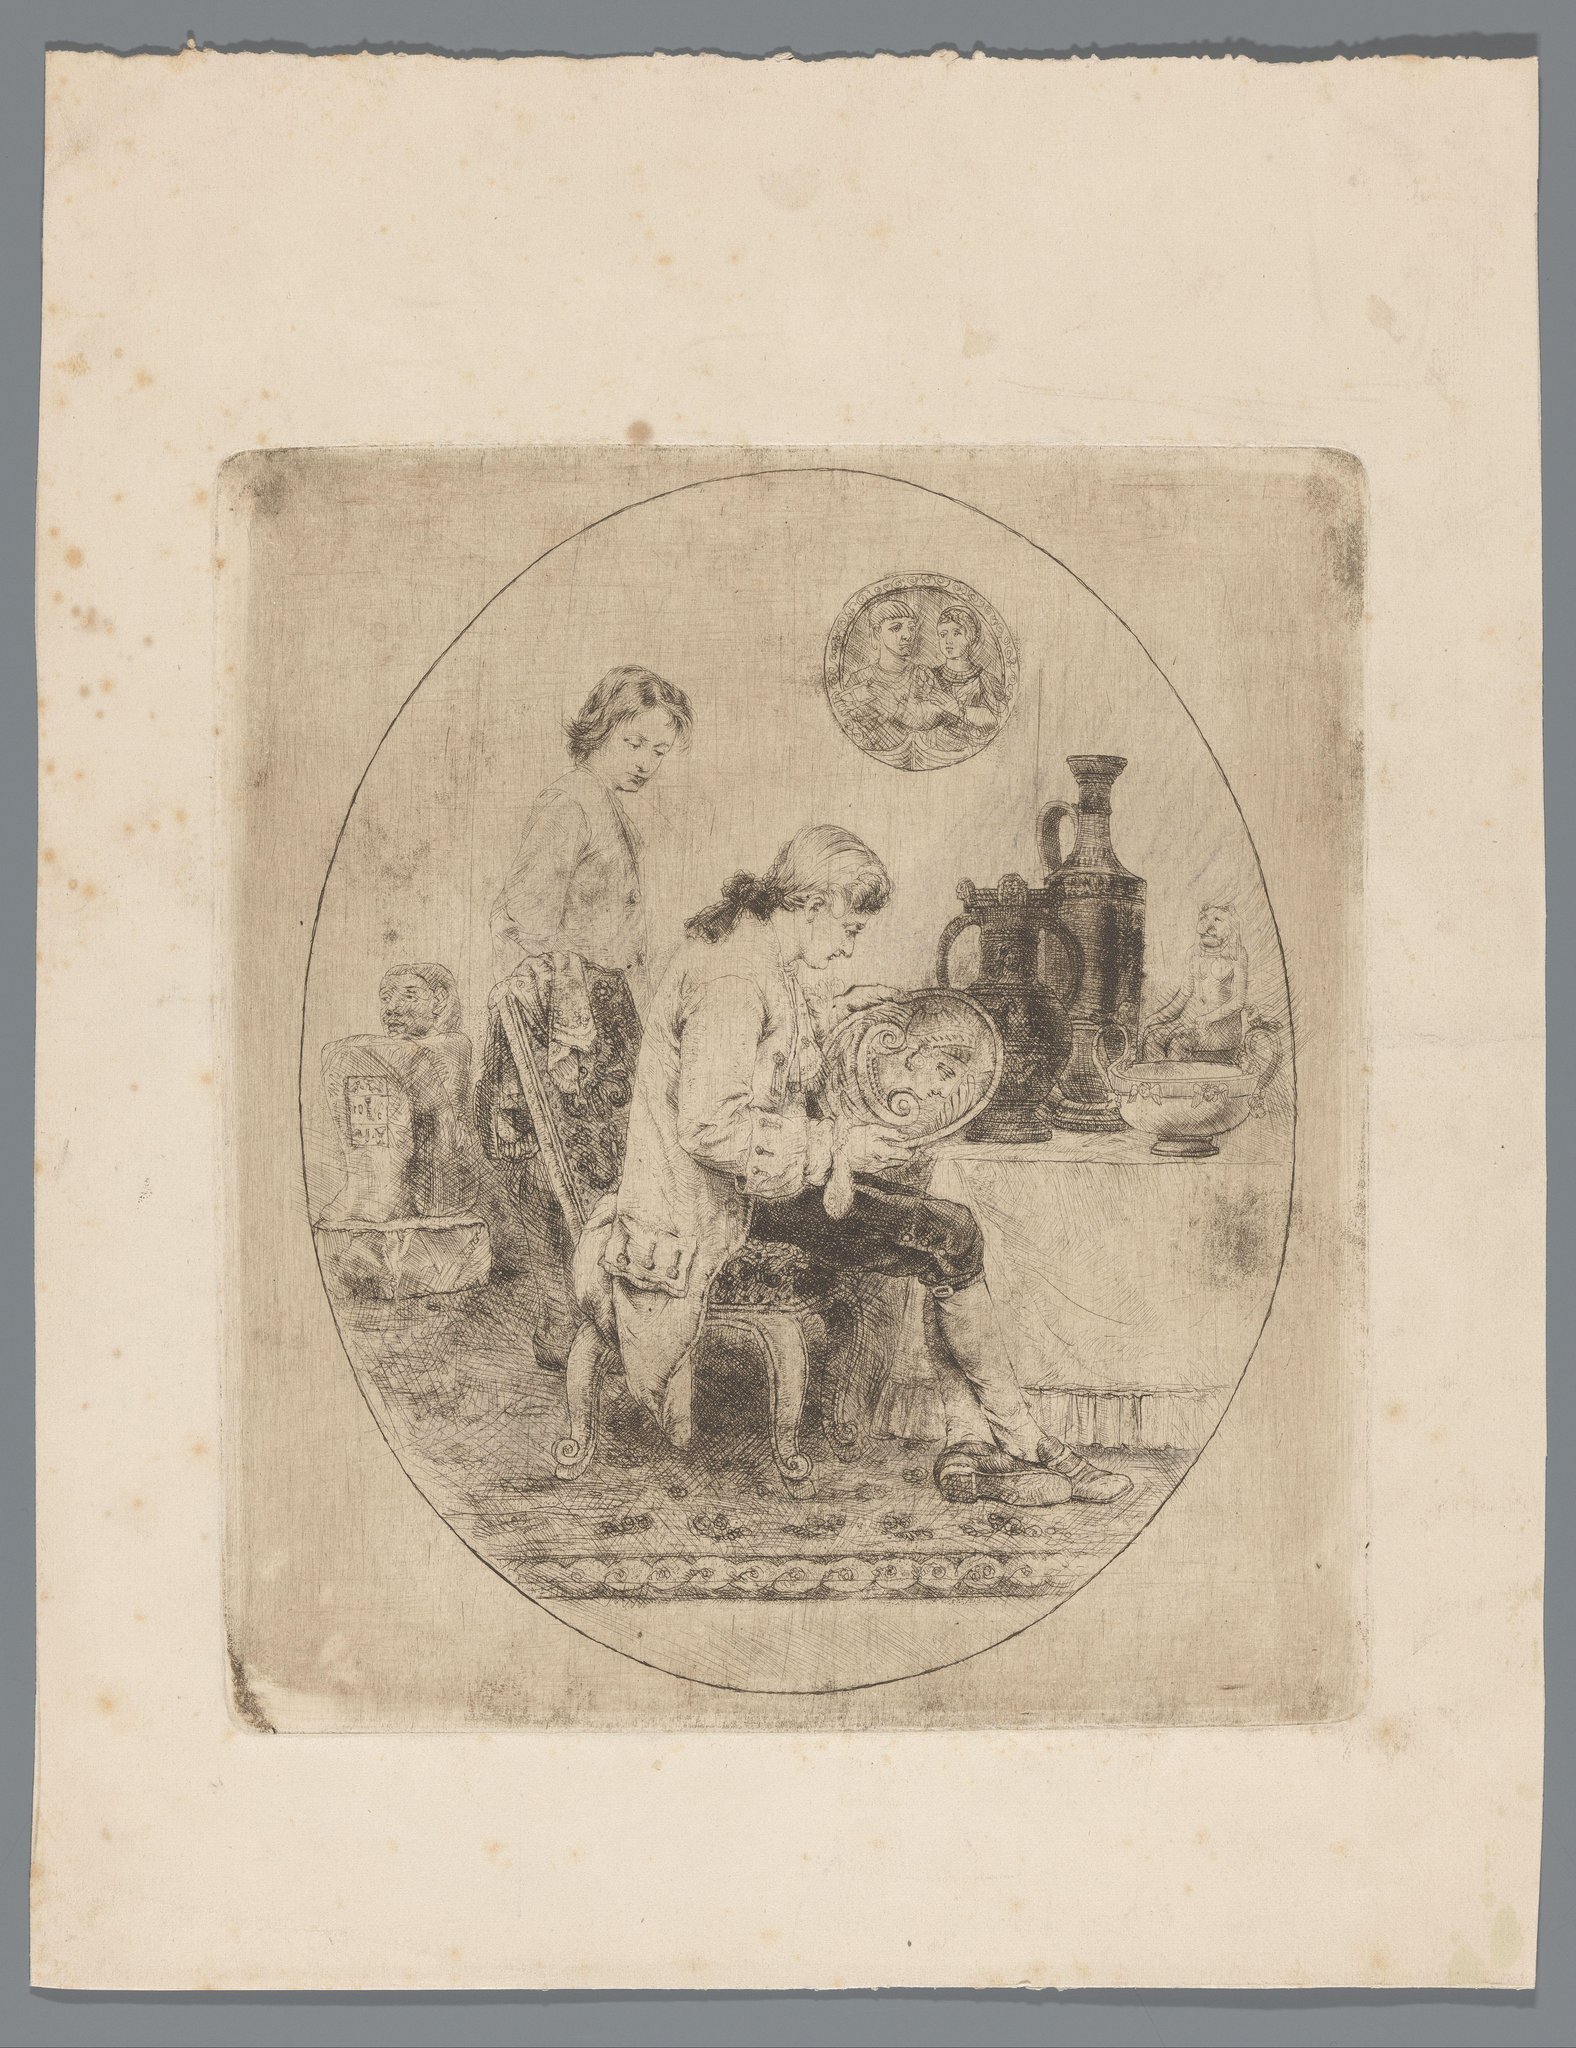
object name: print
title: Kunstliefhebber bestudeert antiek porselein en aardewerk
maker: willem linnig (ii)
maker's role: print maker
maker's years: 1842-1890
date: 1881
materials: paper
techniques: drypoint, etching, intaglio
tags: art collector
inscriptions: collector's mark: Lugt 2228